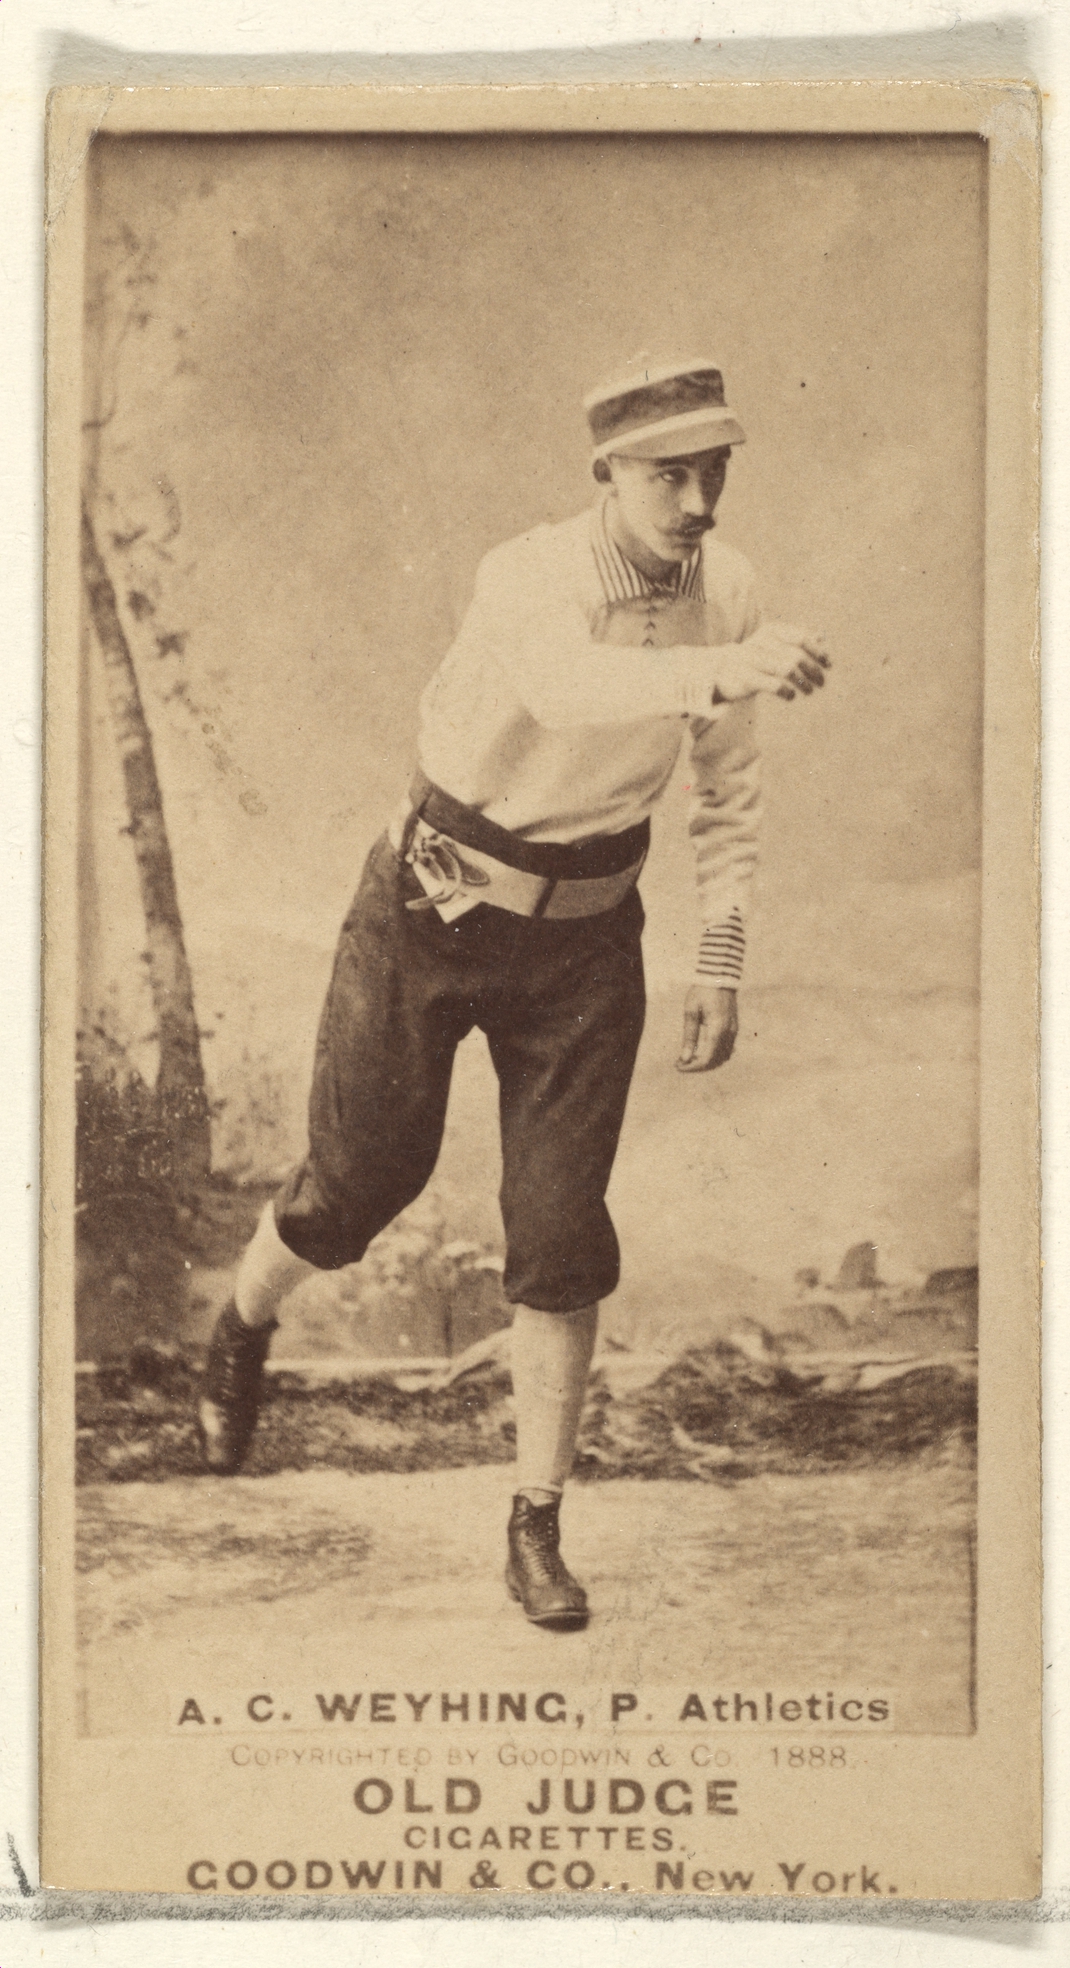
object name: baseball card, photograph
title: A.C. Weyhing, Pitcher, Philadelphia Athletics, from the Old Judge series (N172) for Old Judge Cigarettes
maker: goodwin & company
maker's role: publisher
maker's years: 1850-1950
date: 1888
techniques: albumen silver print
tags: men,portraits,baseball,athletes